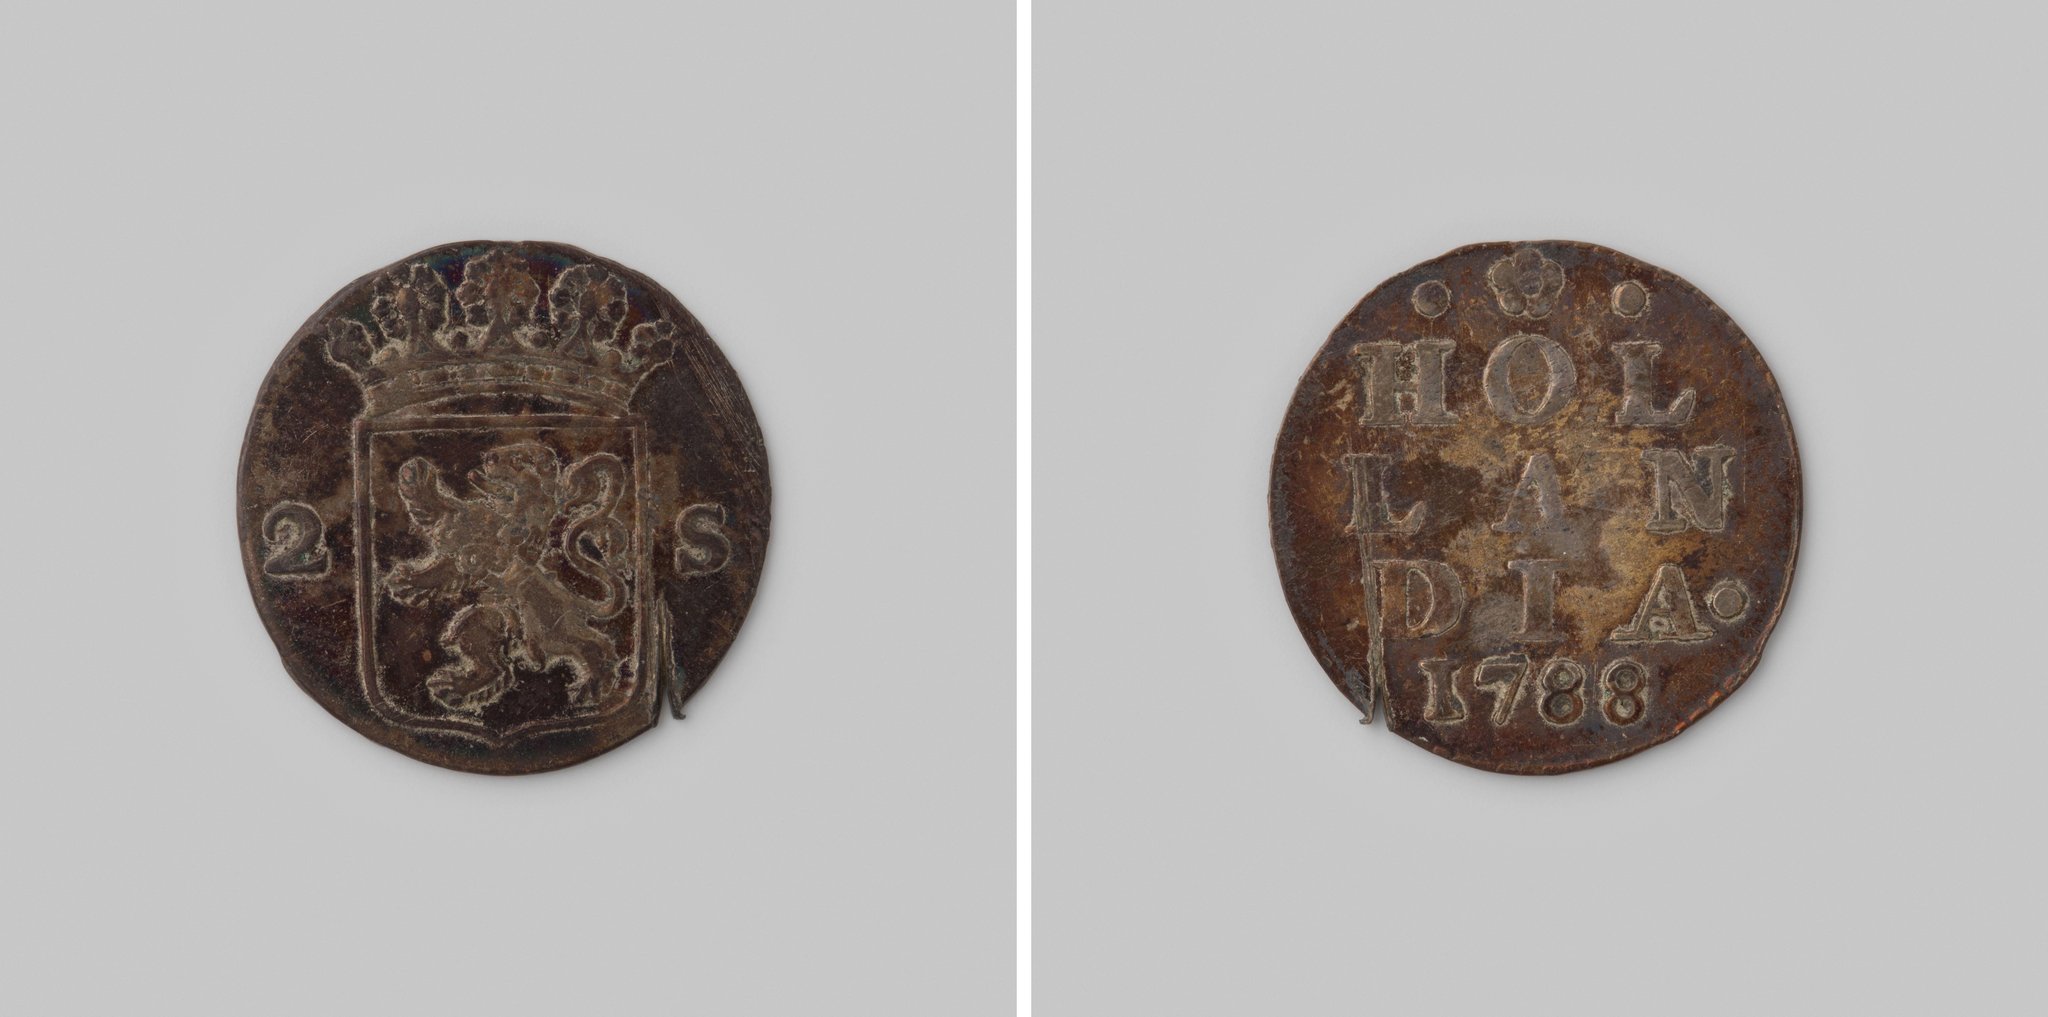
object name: coin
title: Hollandse dubbele stuiver, 1788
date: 1788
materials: silver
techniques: striking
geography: dordrecht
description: Zilveren munt. Voorzijde: tussen waarde-aanduiding 2 S gekroond wapenschild van Holland. Keerzijde: opschrift: provincienaam in drie regels, daaronder jaartal.